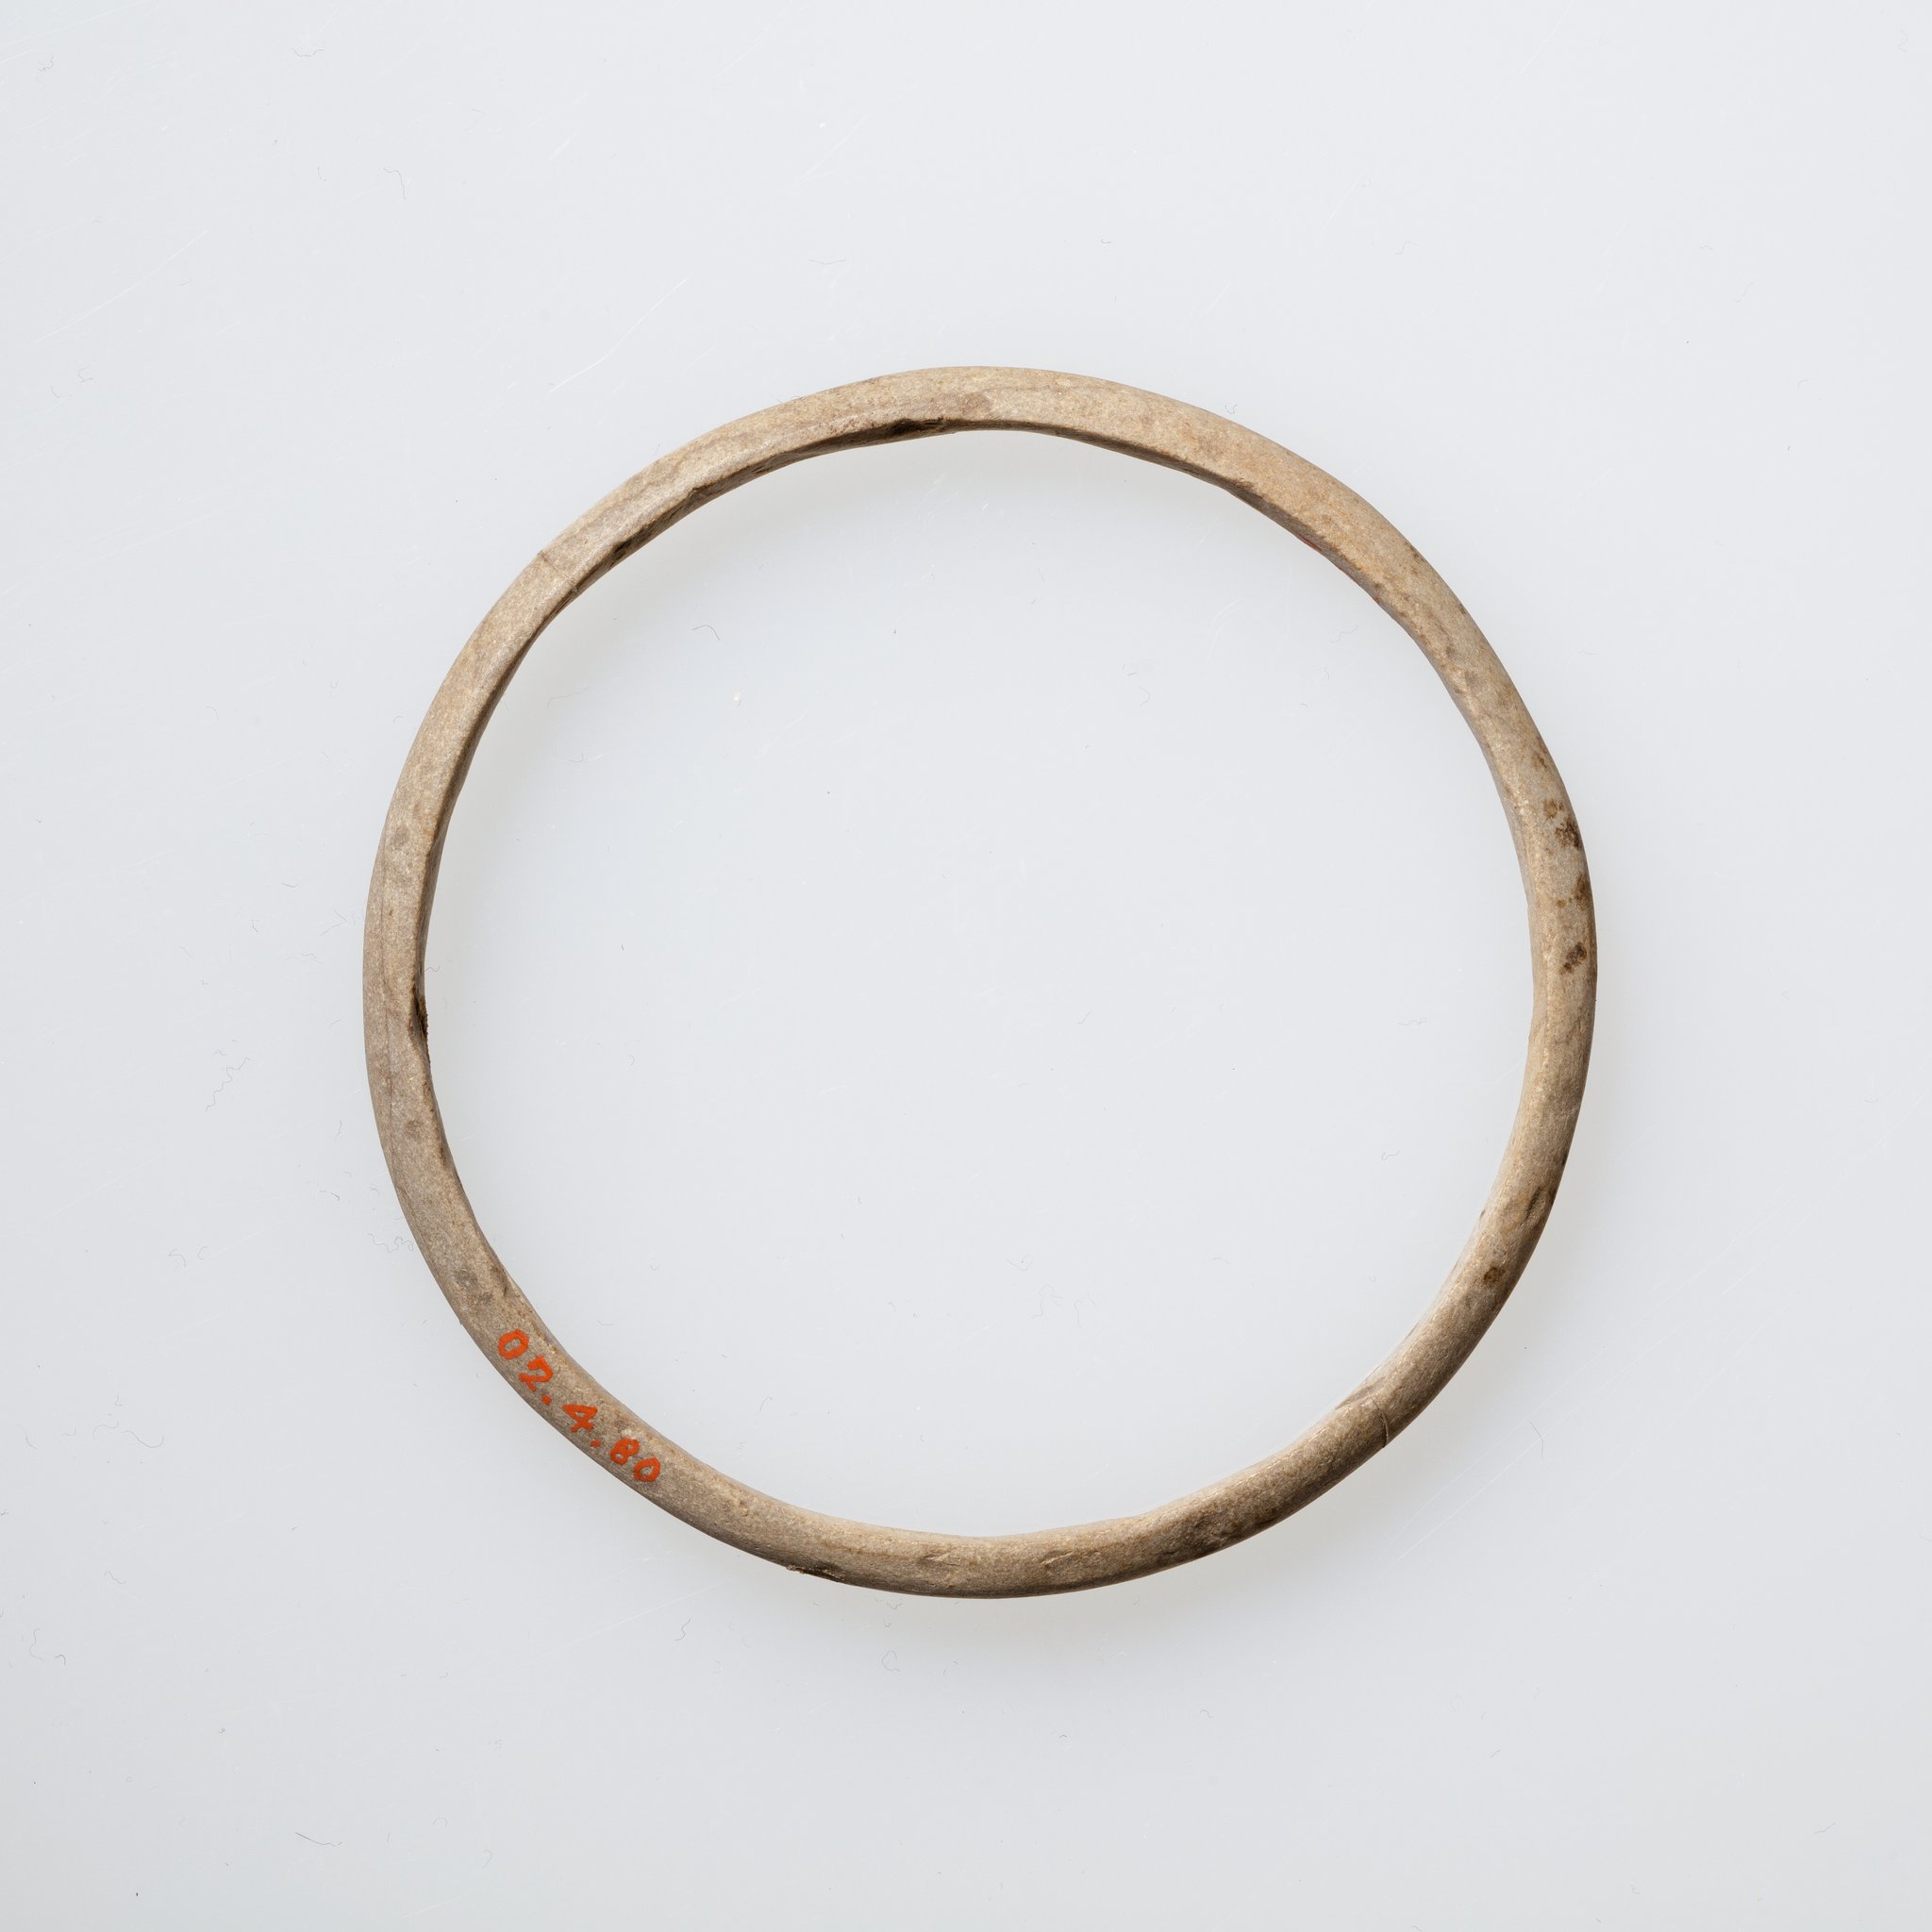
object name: bracelet bangle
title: Bracelet (Bangle)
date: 3100-2649 BCE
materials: stone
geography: egypt